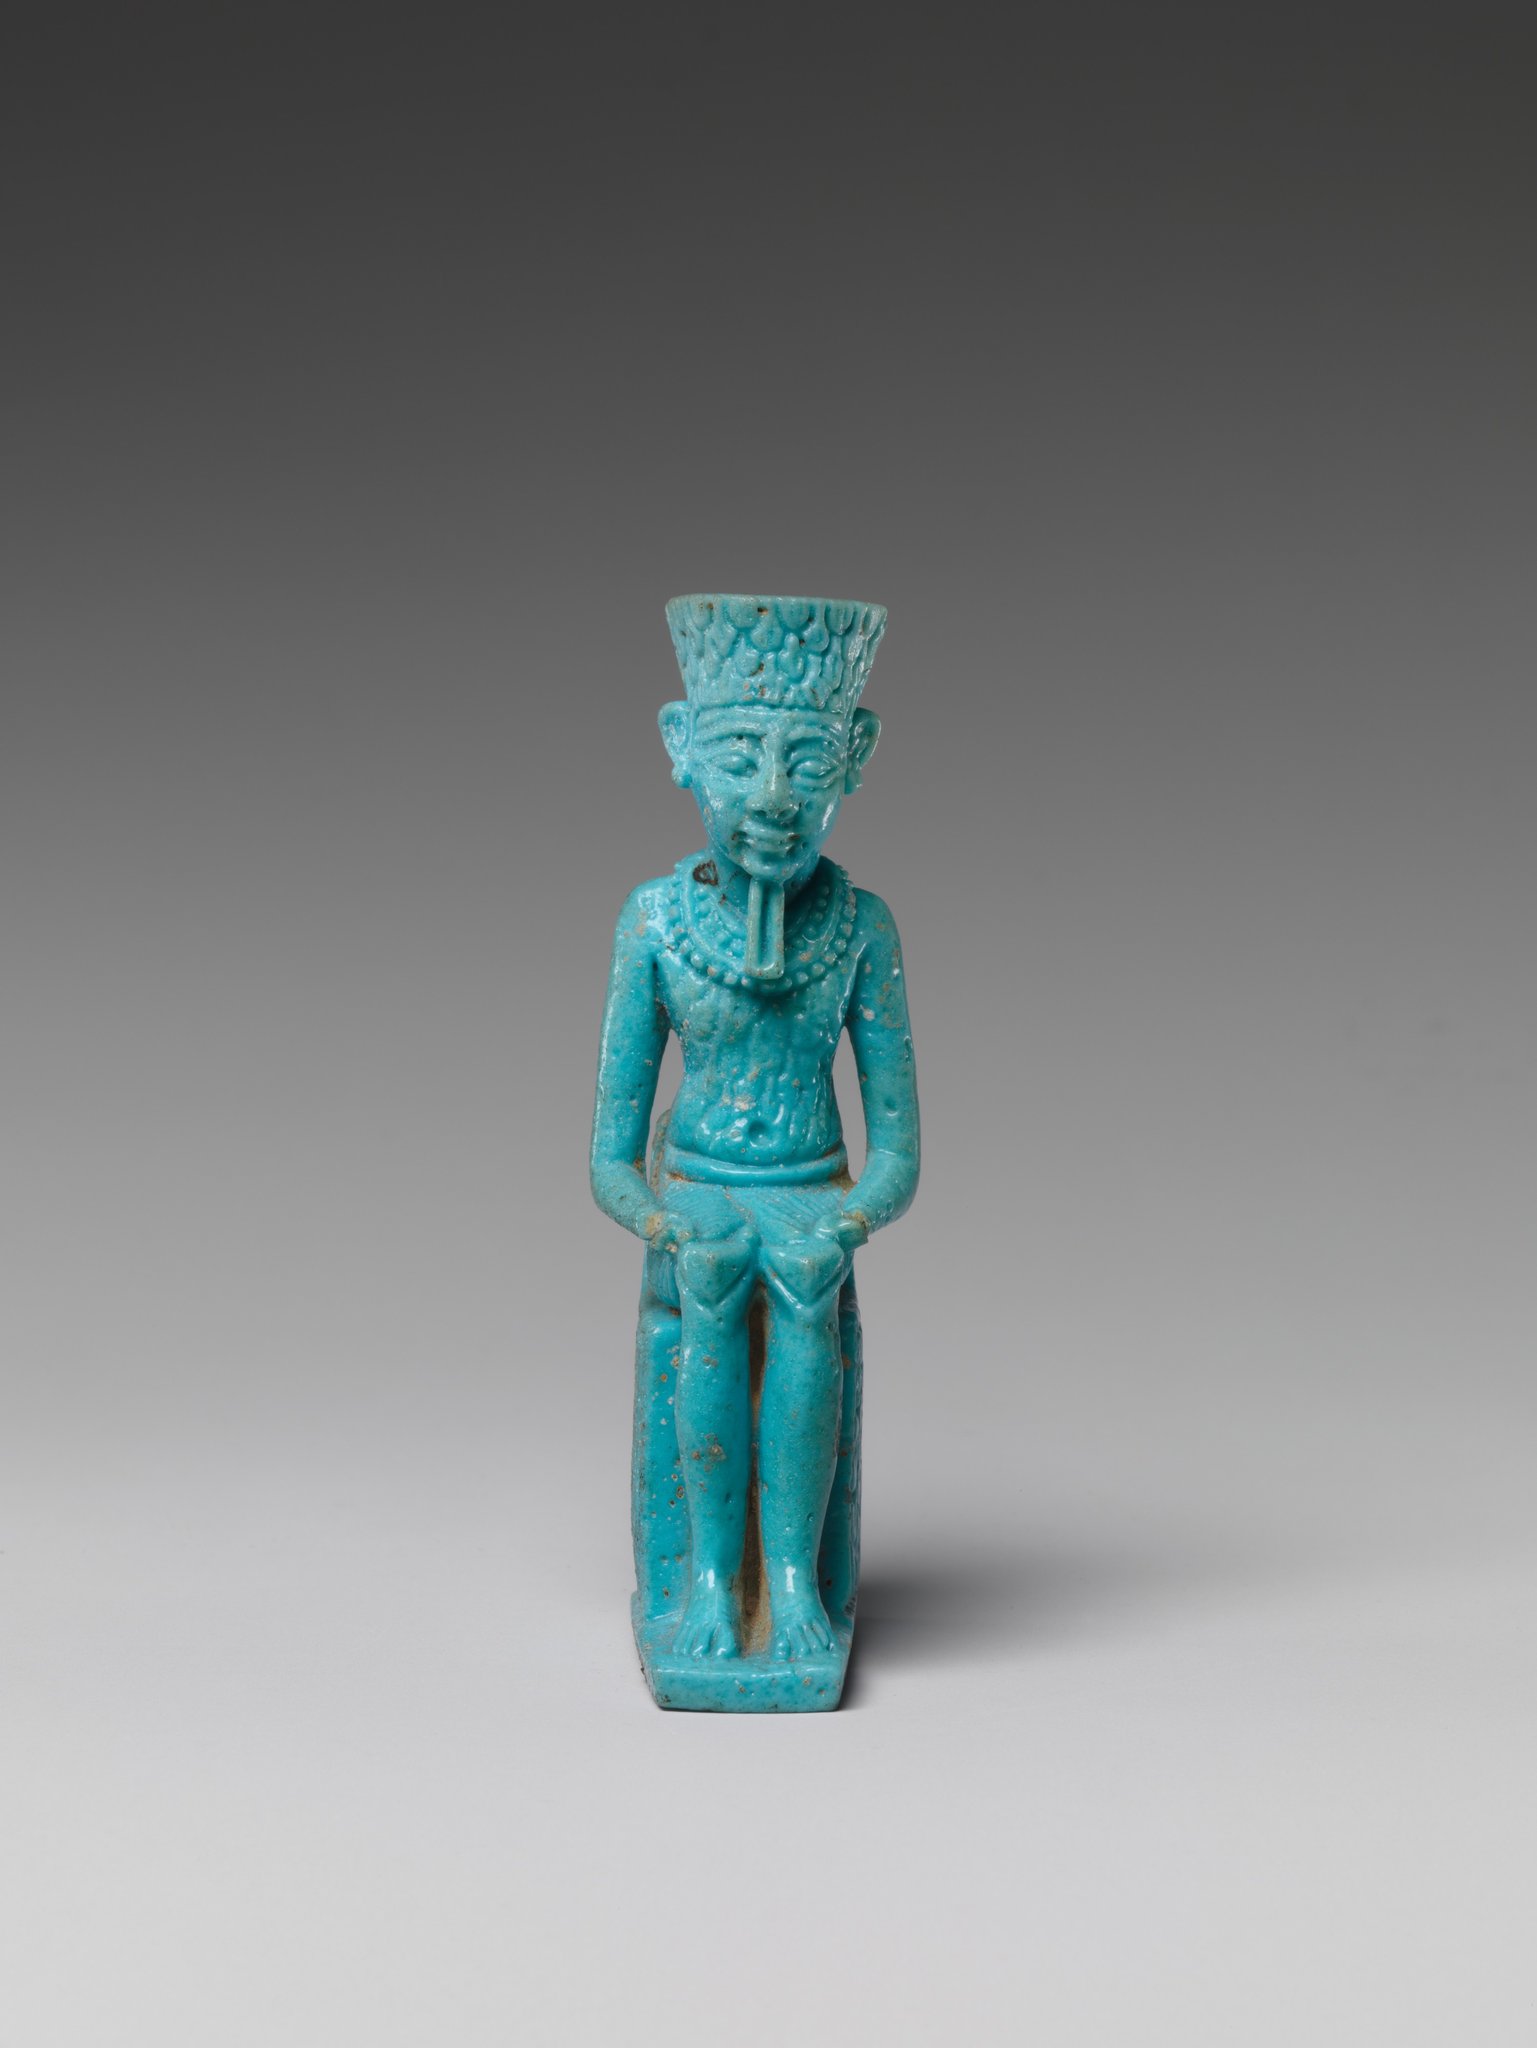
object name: amun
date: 332-330 BCE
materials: faience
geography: egypt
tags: amun